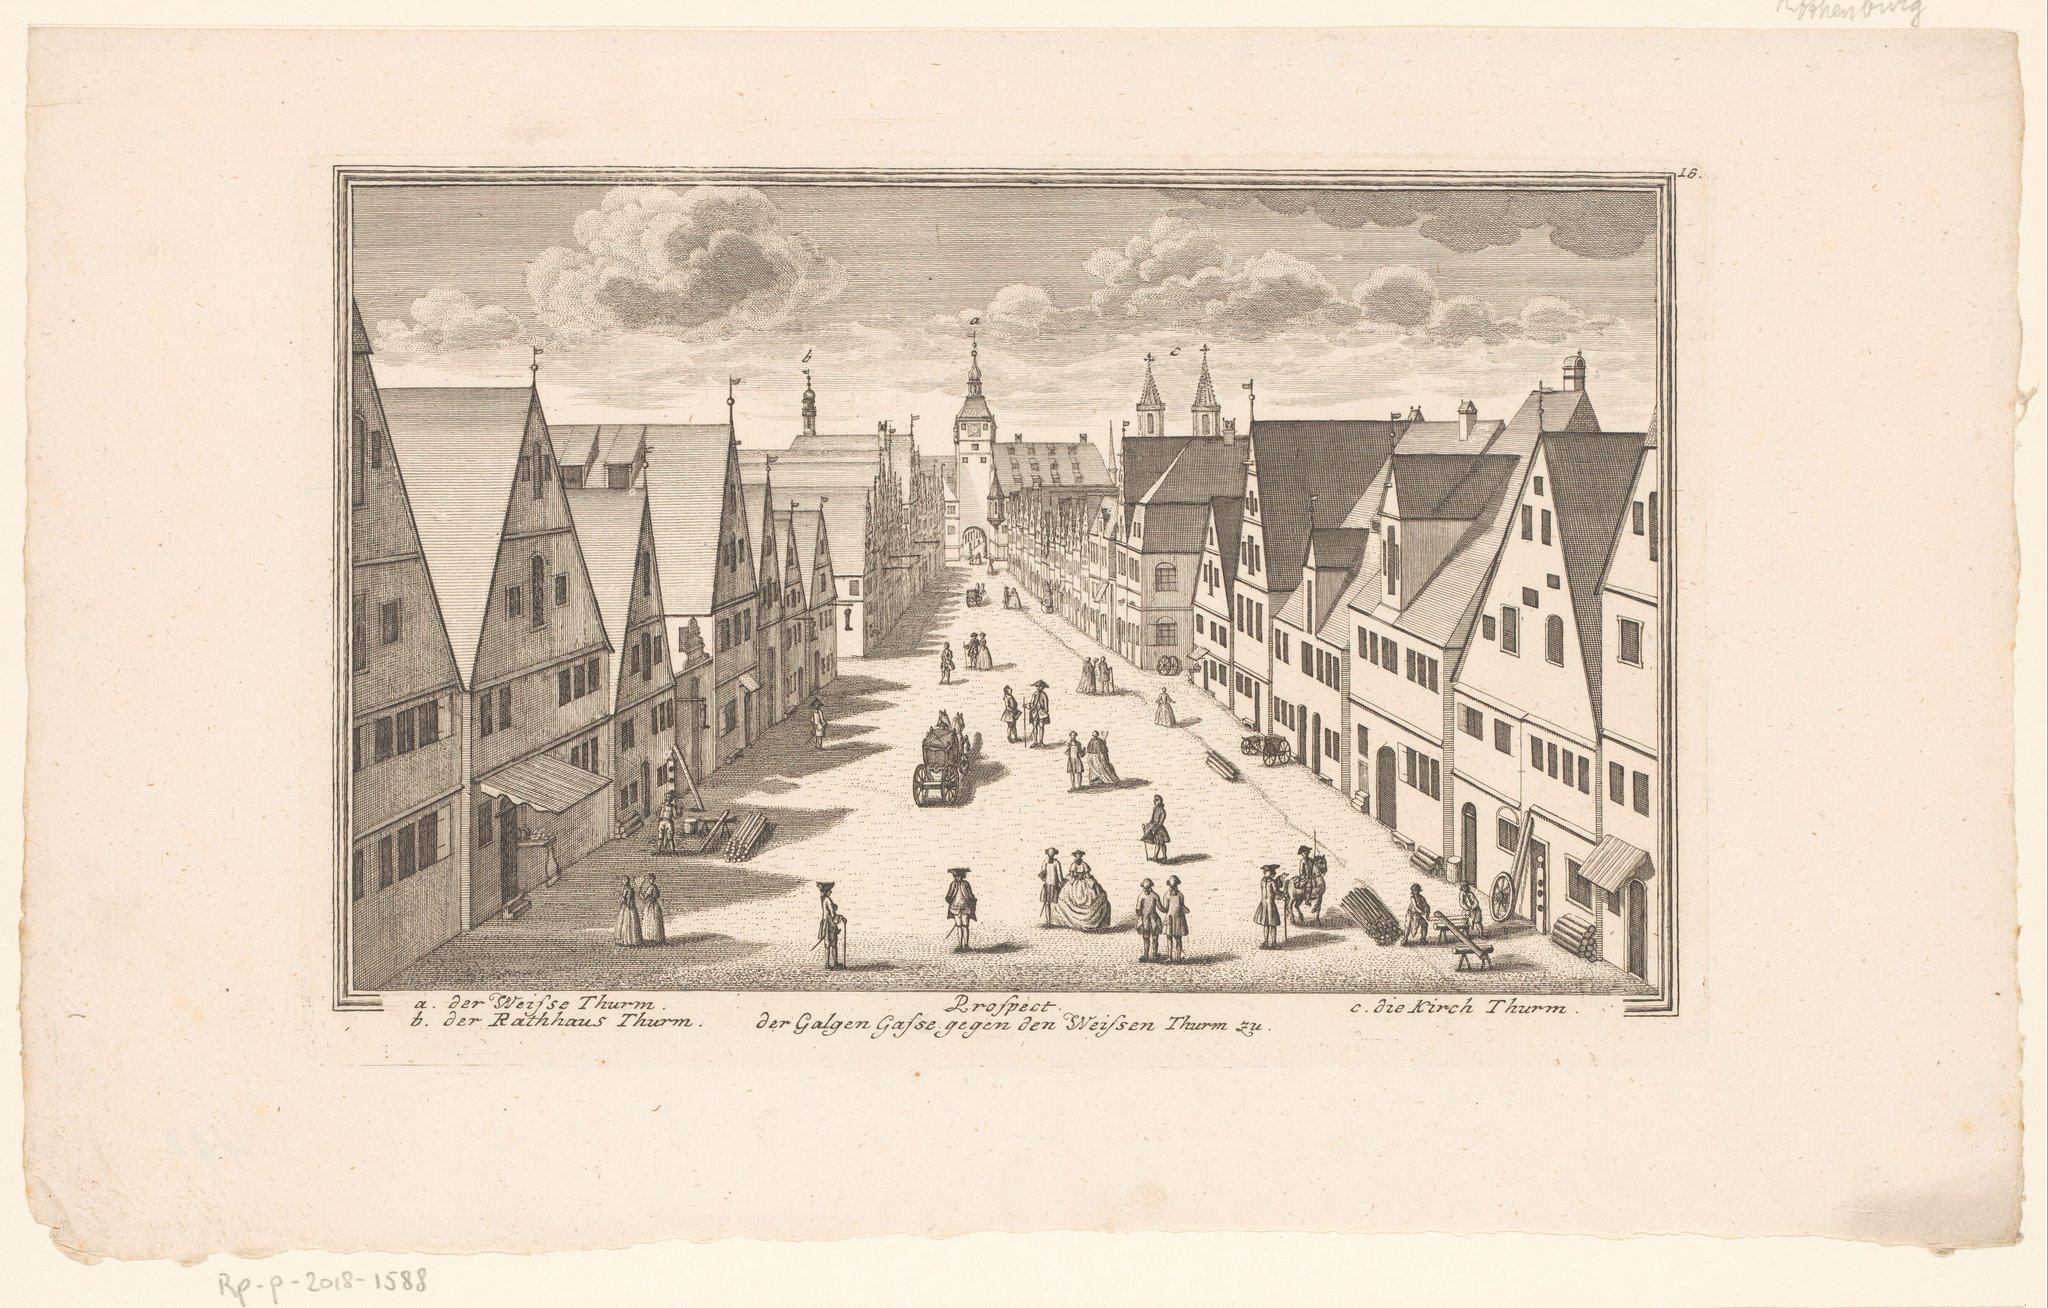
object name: print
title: Gezicht op de Galgengasse, te Rothenbrug ob der Tauber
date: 1758-1796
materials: paper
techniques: engraving, etching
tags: street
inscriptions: collector's mark: Lugt 2228